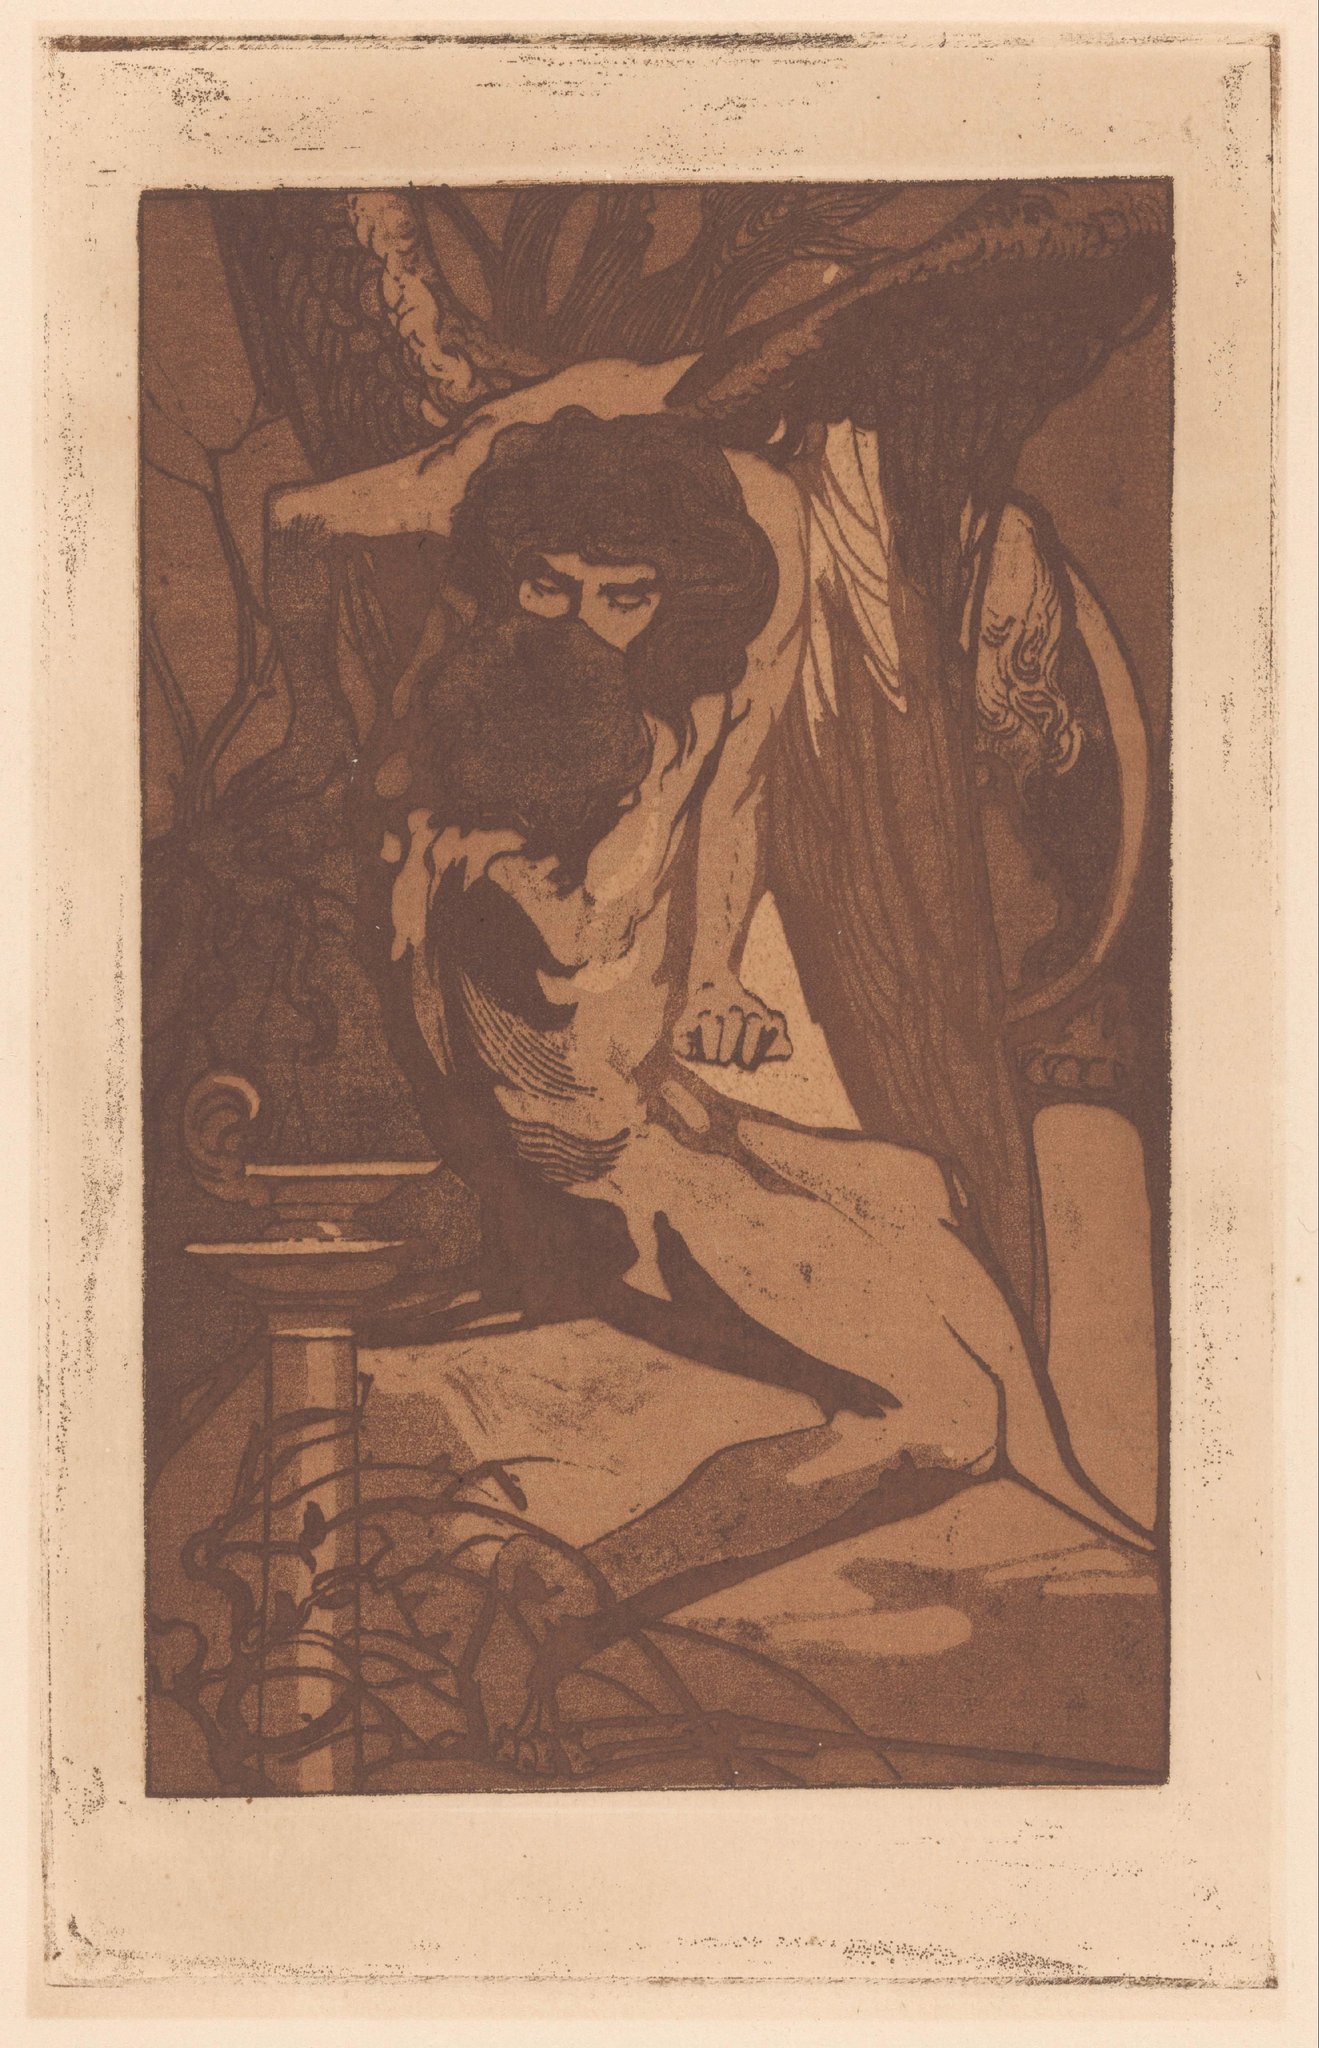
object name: print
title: Oedipus en de sfinx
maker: johannes josephus aarts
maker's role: draughtsman, print maker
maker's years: 1871-1934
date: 1881-1934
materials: paper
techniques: aquatint, etching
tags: oedipus and the sphinx; he solves the riddle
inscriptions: collector's mark: Lugt 2760, collector's mark: Lugt 2228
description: Oedipus, in zittende positie, die benaderd wordt door de sfinx, een monster met het hoofd van een vrouw, het lichaam van een leeuw en de vleugels van een adelaar.